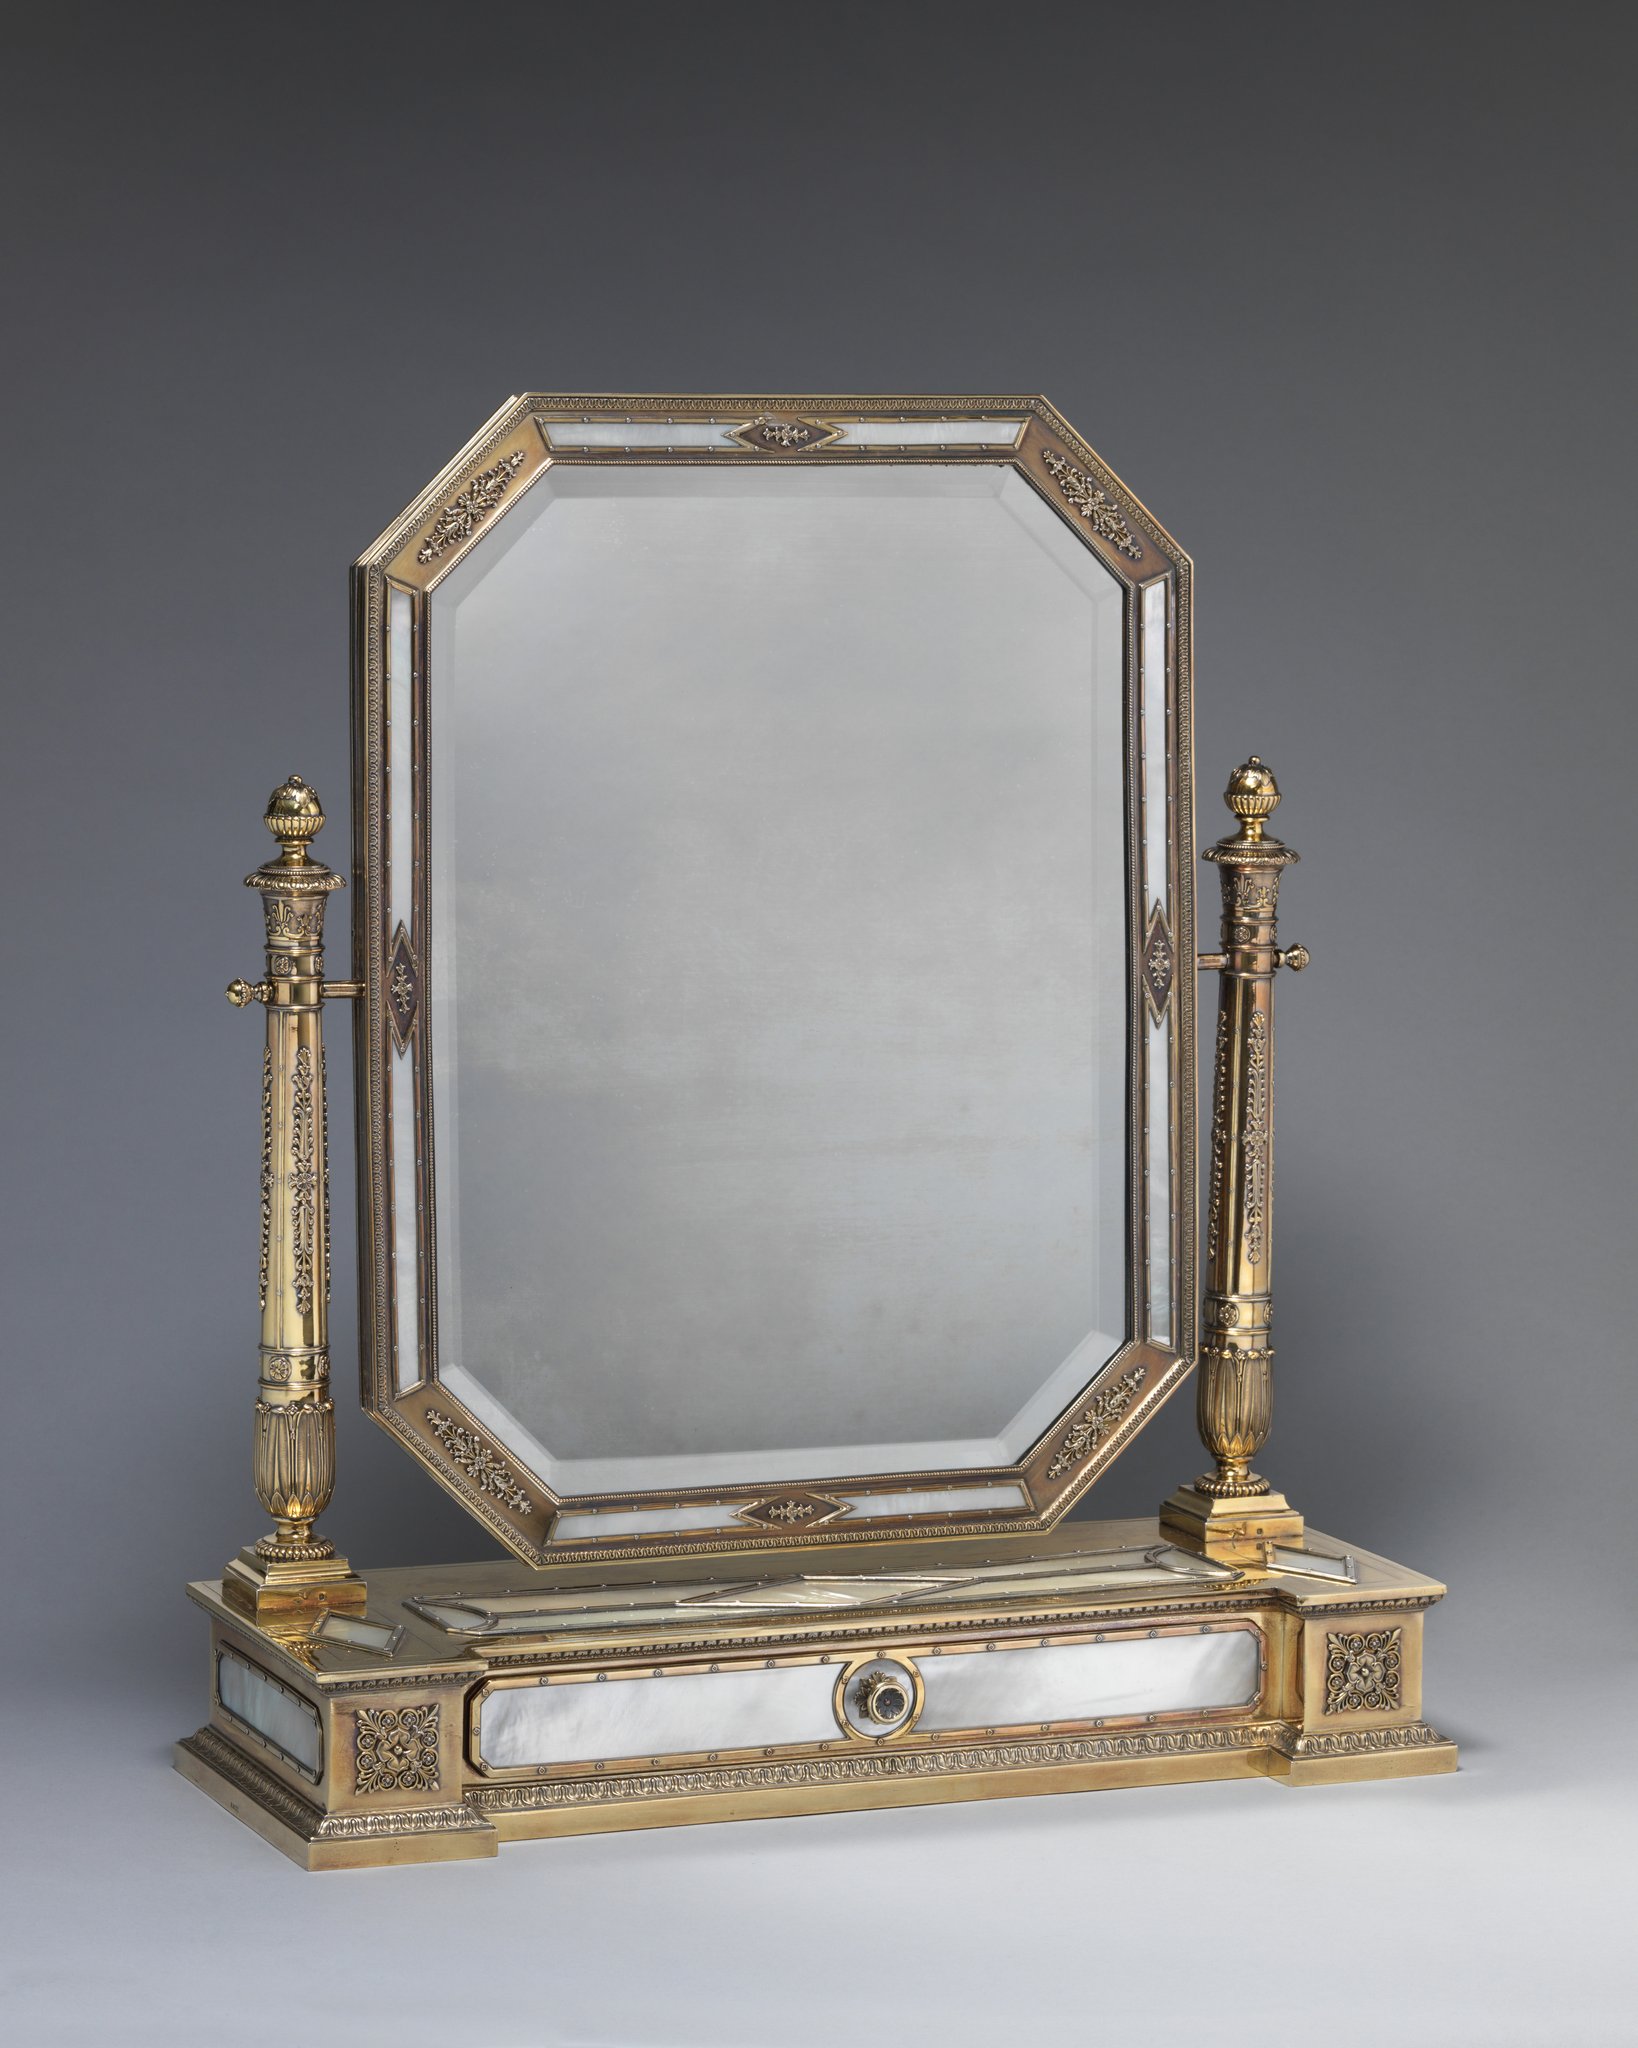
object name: dressing table mirror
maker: andré aucoc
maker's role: maker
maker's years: 1825-1925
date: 1887-1911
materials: mother of pearl, silver gilt